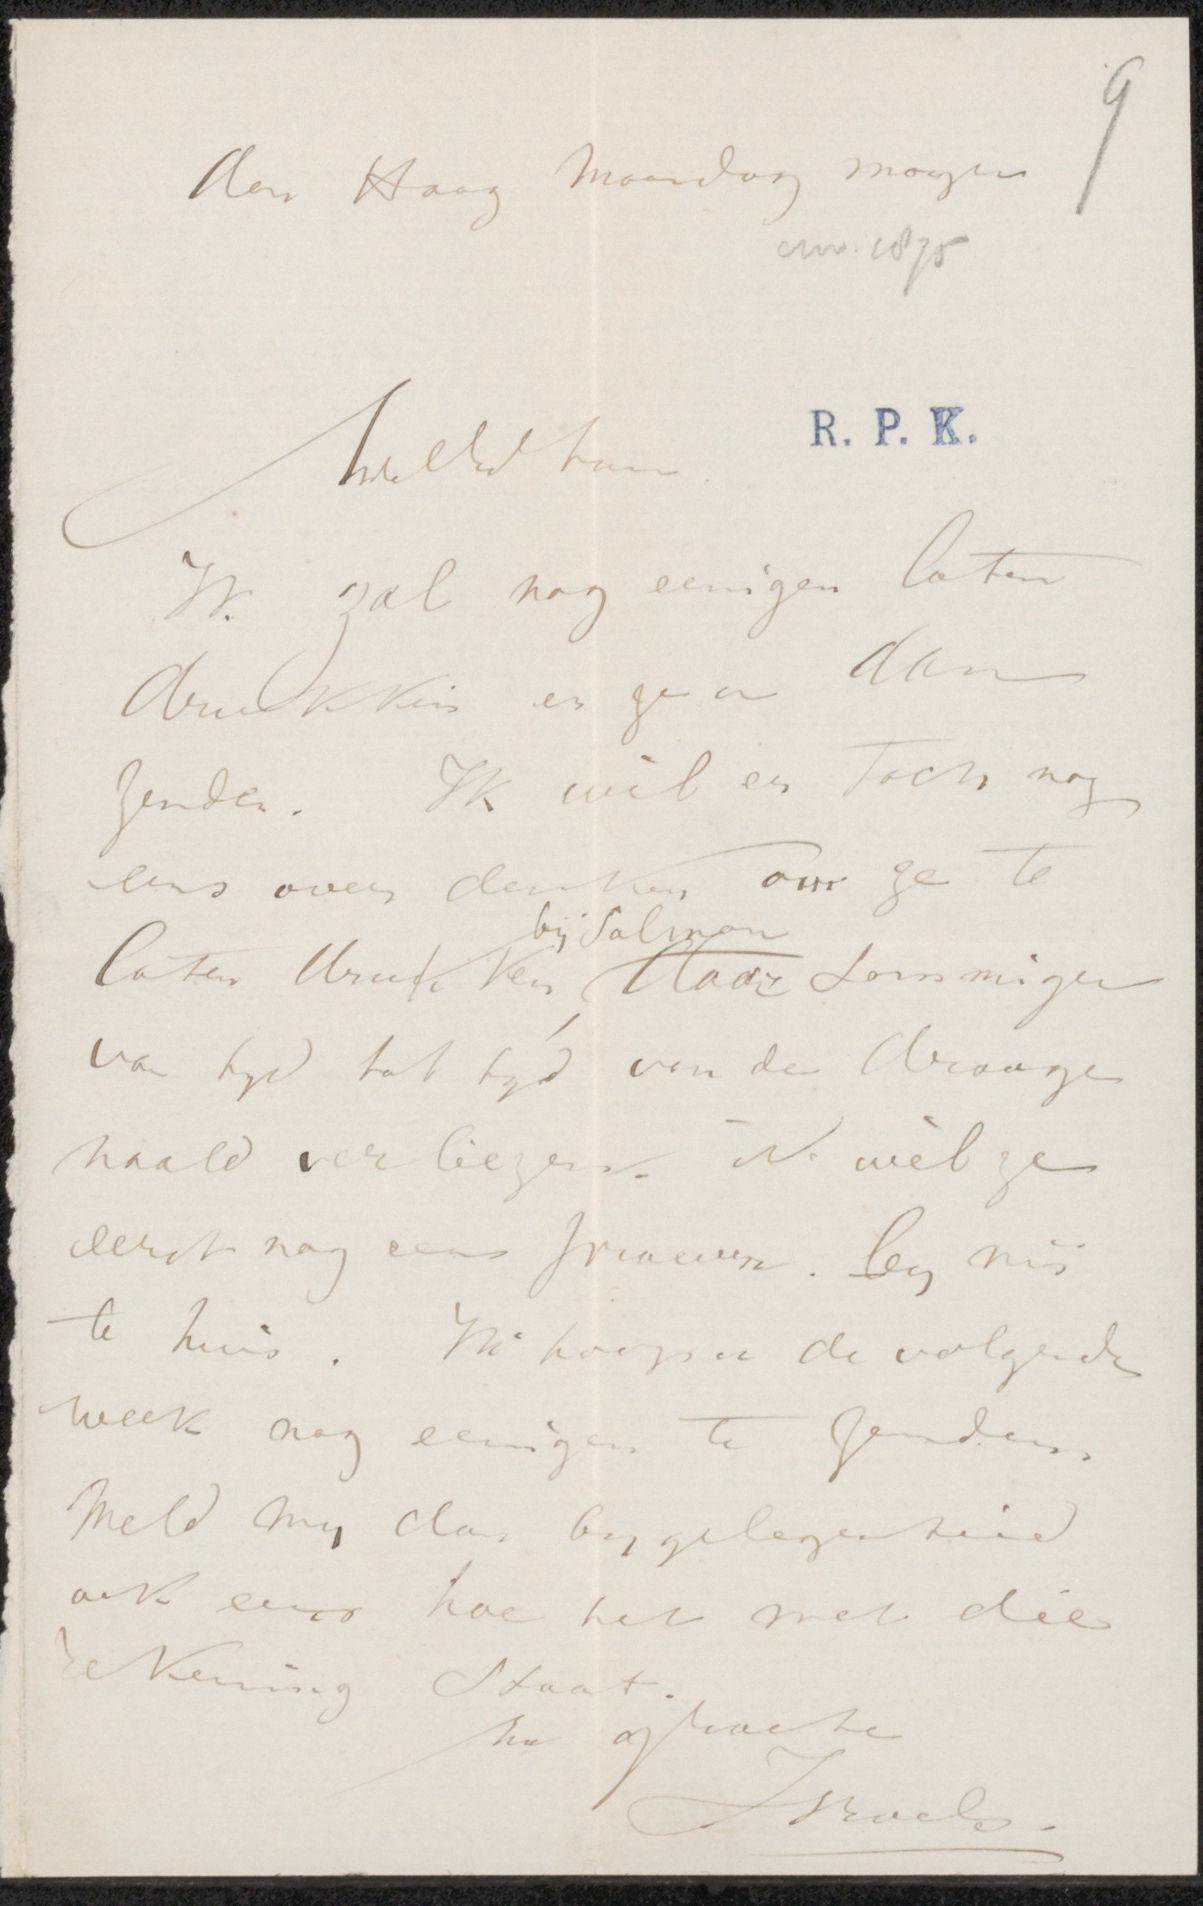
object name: letter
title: Brief aan Frans Buffa en Zonen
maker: jozef israëls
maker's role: draughtsman, painter, print maker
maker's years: 1824-1911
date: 1834-1911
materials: ink, paper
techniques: pen, writing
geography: the hague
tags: publisher, alfred salmon, the graphic arts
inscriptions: collector's mark: Lugt 2233, watermark